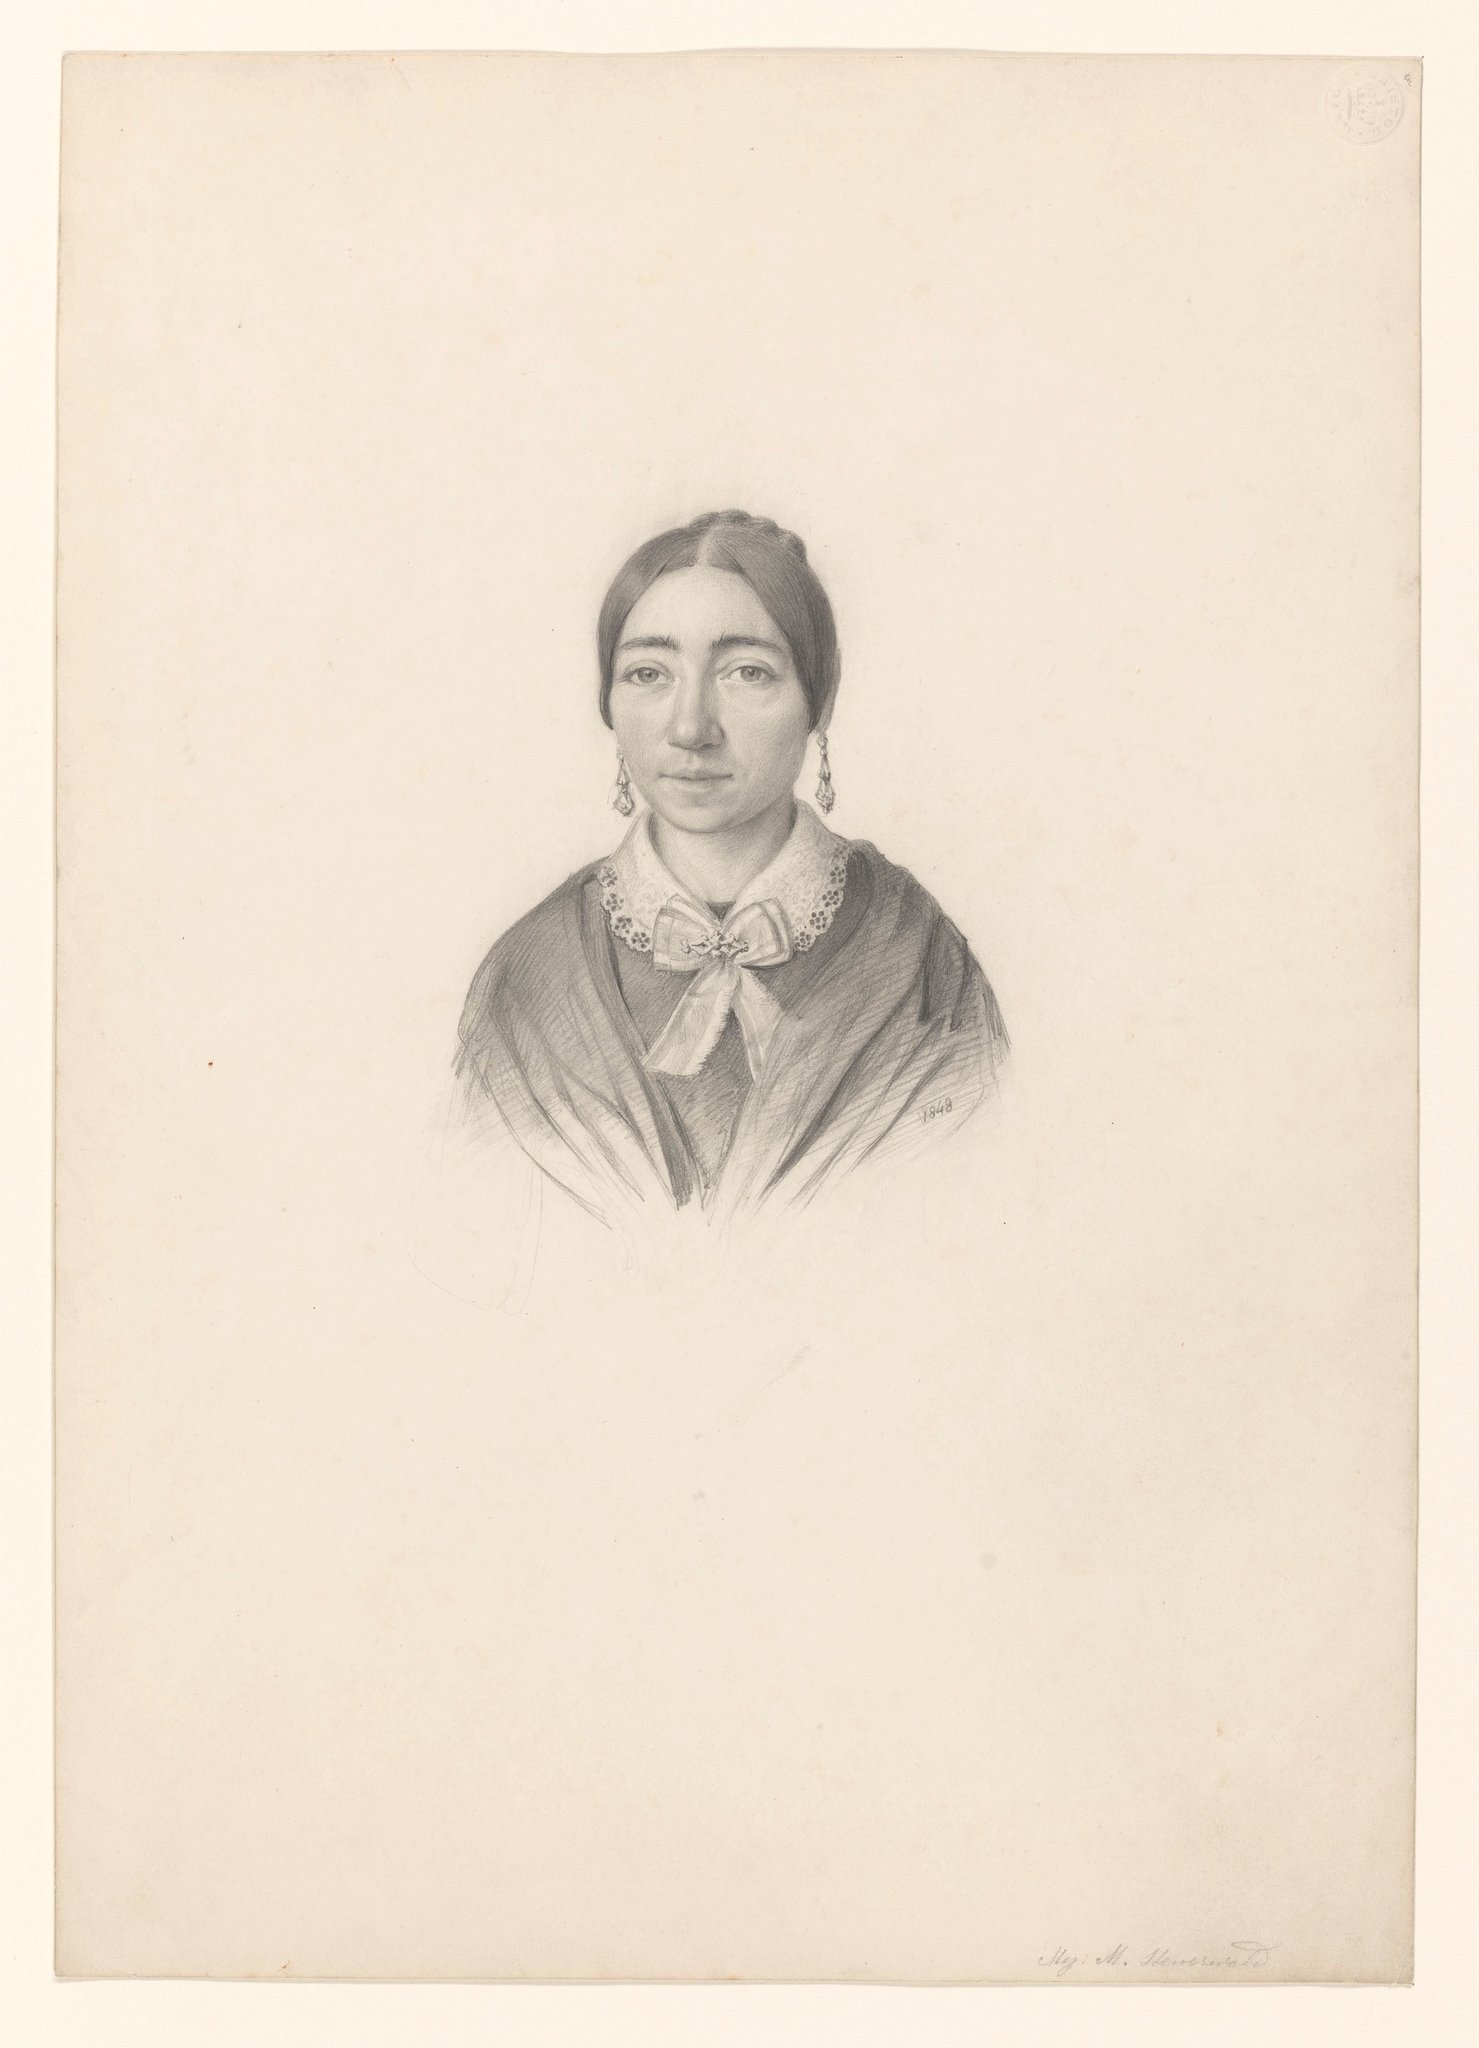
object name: drawing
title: Portret van Maria Lucia Steuerwald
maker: christian heinrich gottlieb steuerwald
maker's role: draughtsman, print maker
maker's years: 1802-1874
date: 1848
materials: paper, pencil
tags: historical persons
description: Portret van Maria Lucia Steuerwald, zuster van de kunstenaar.